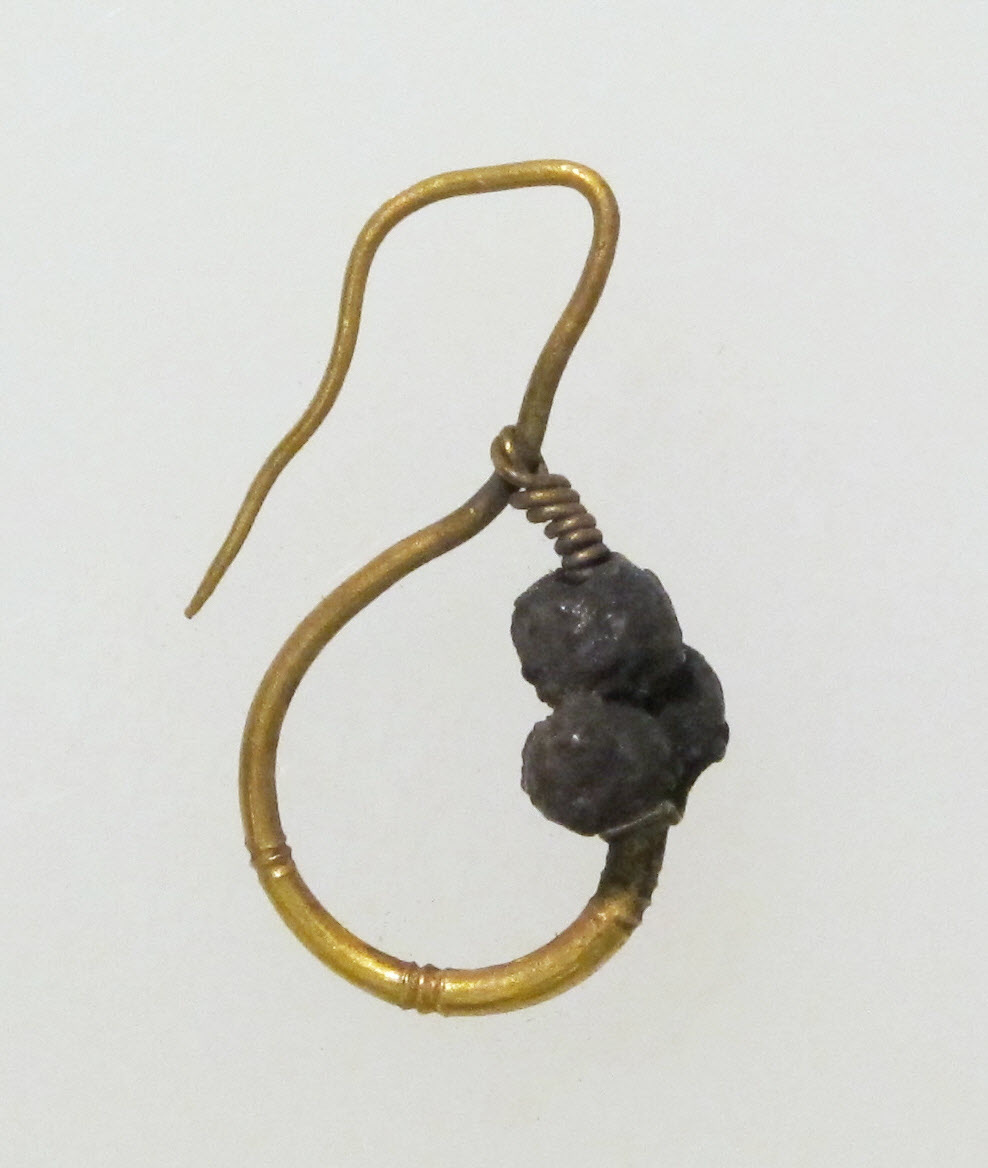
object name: earring, delta shaped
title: Earring, delta-shaped with beads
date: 7000 BCE-330 CE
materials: gold, silver